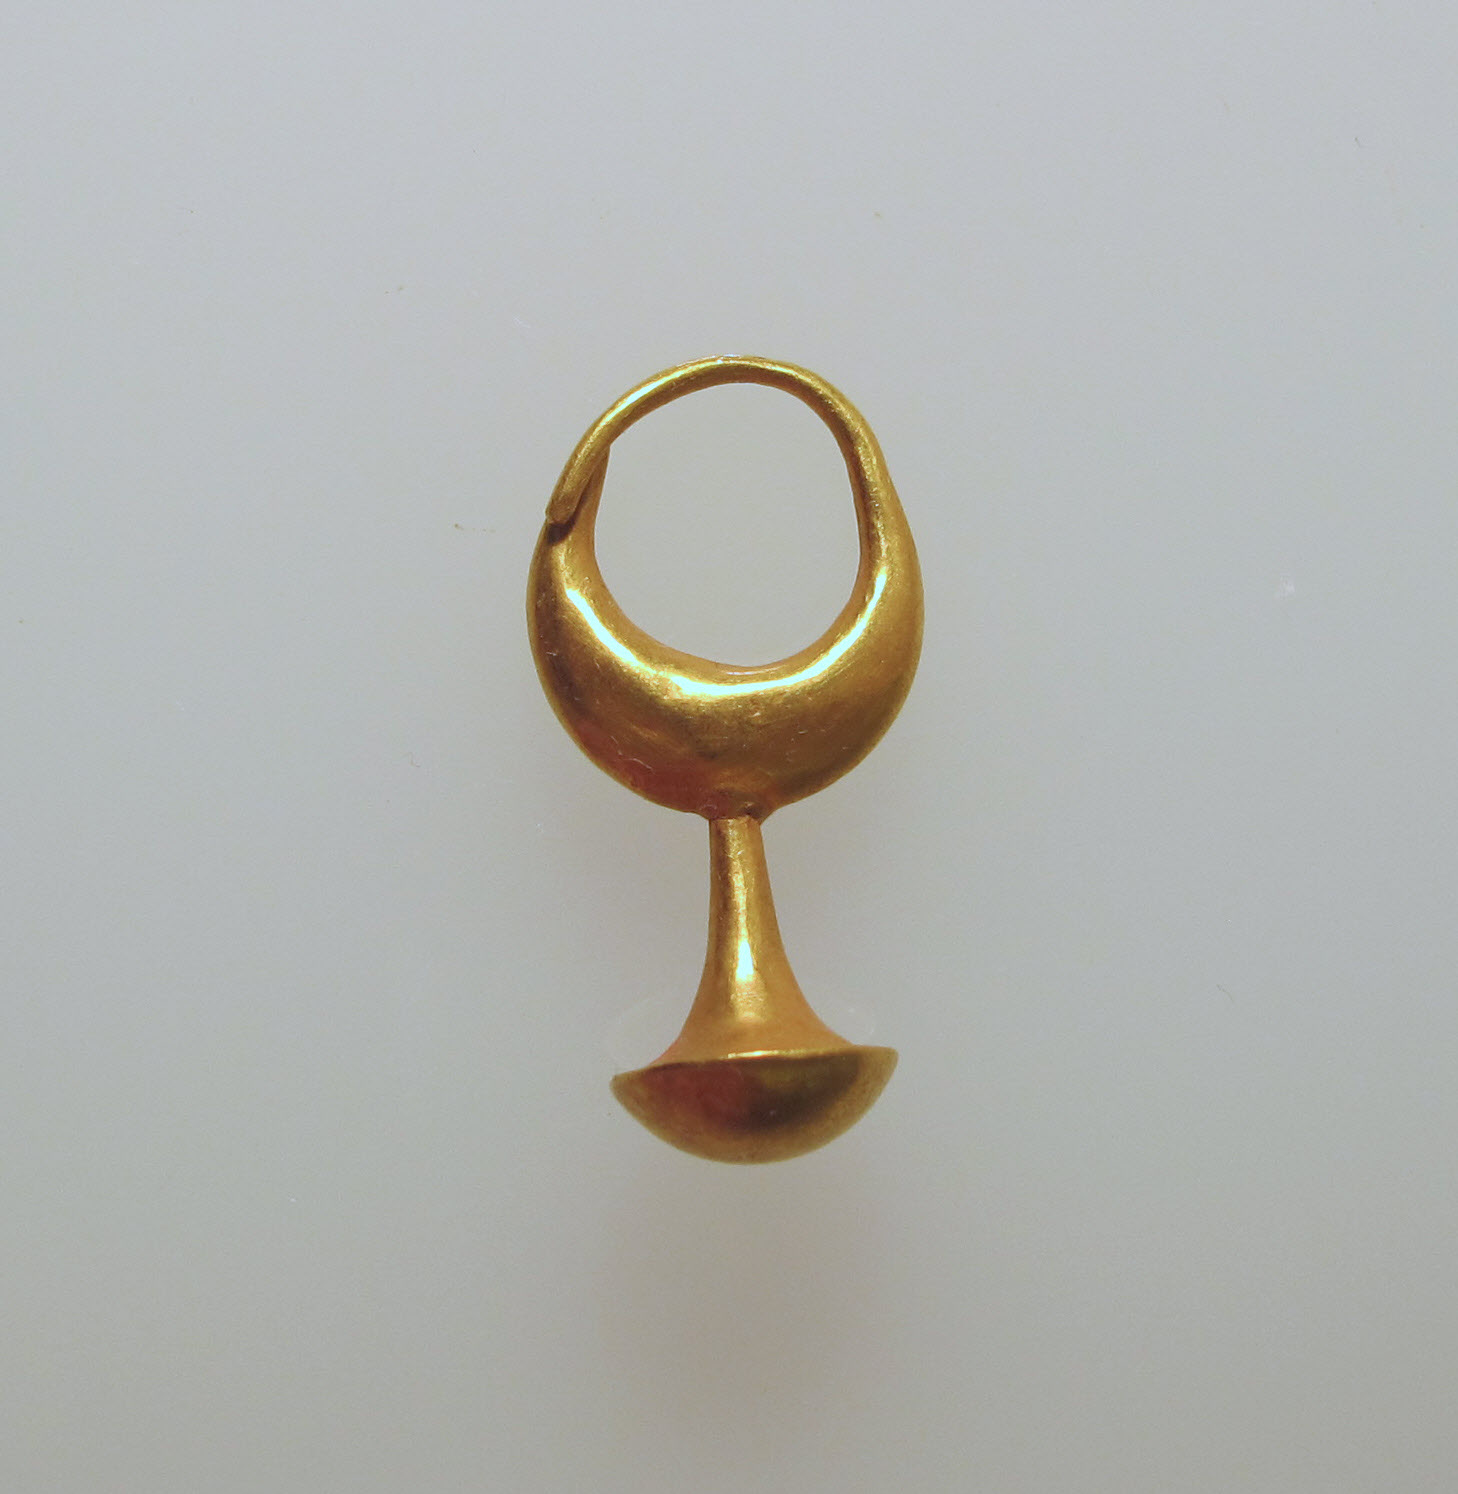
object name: earring with nail head pendant, 12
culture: cypriot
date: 3900 BCE-100 CE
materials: gold